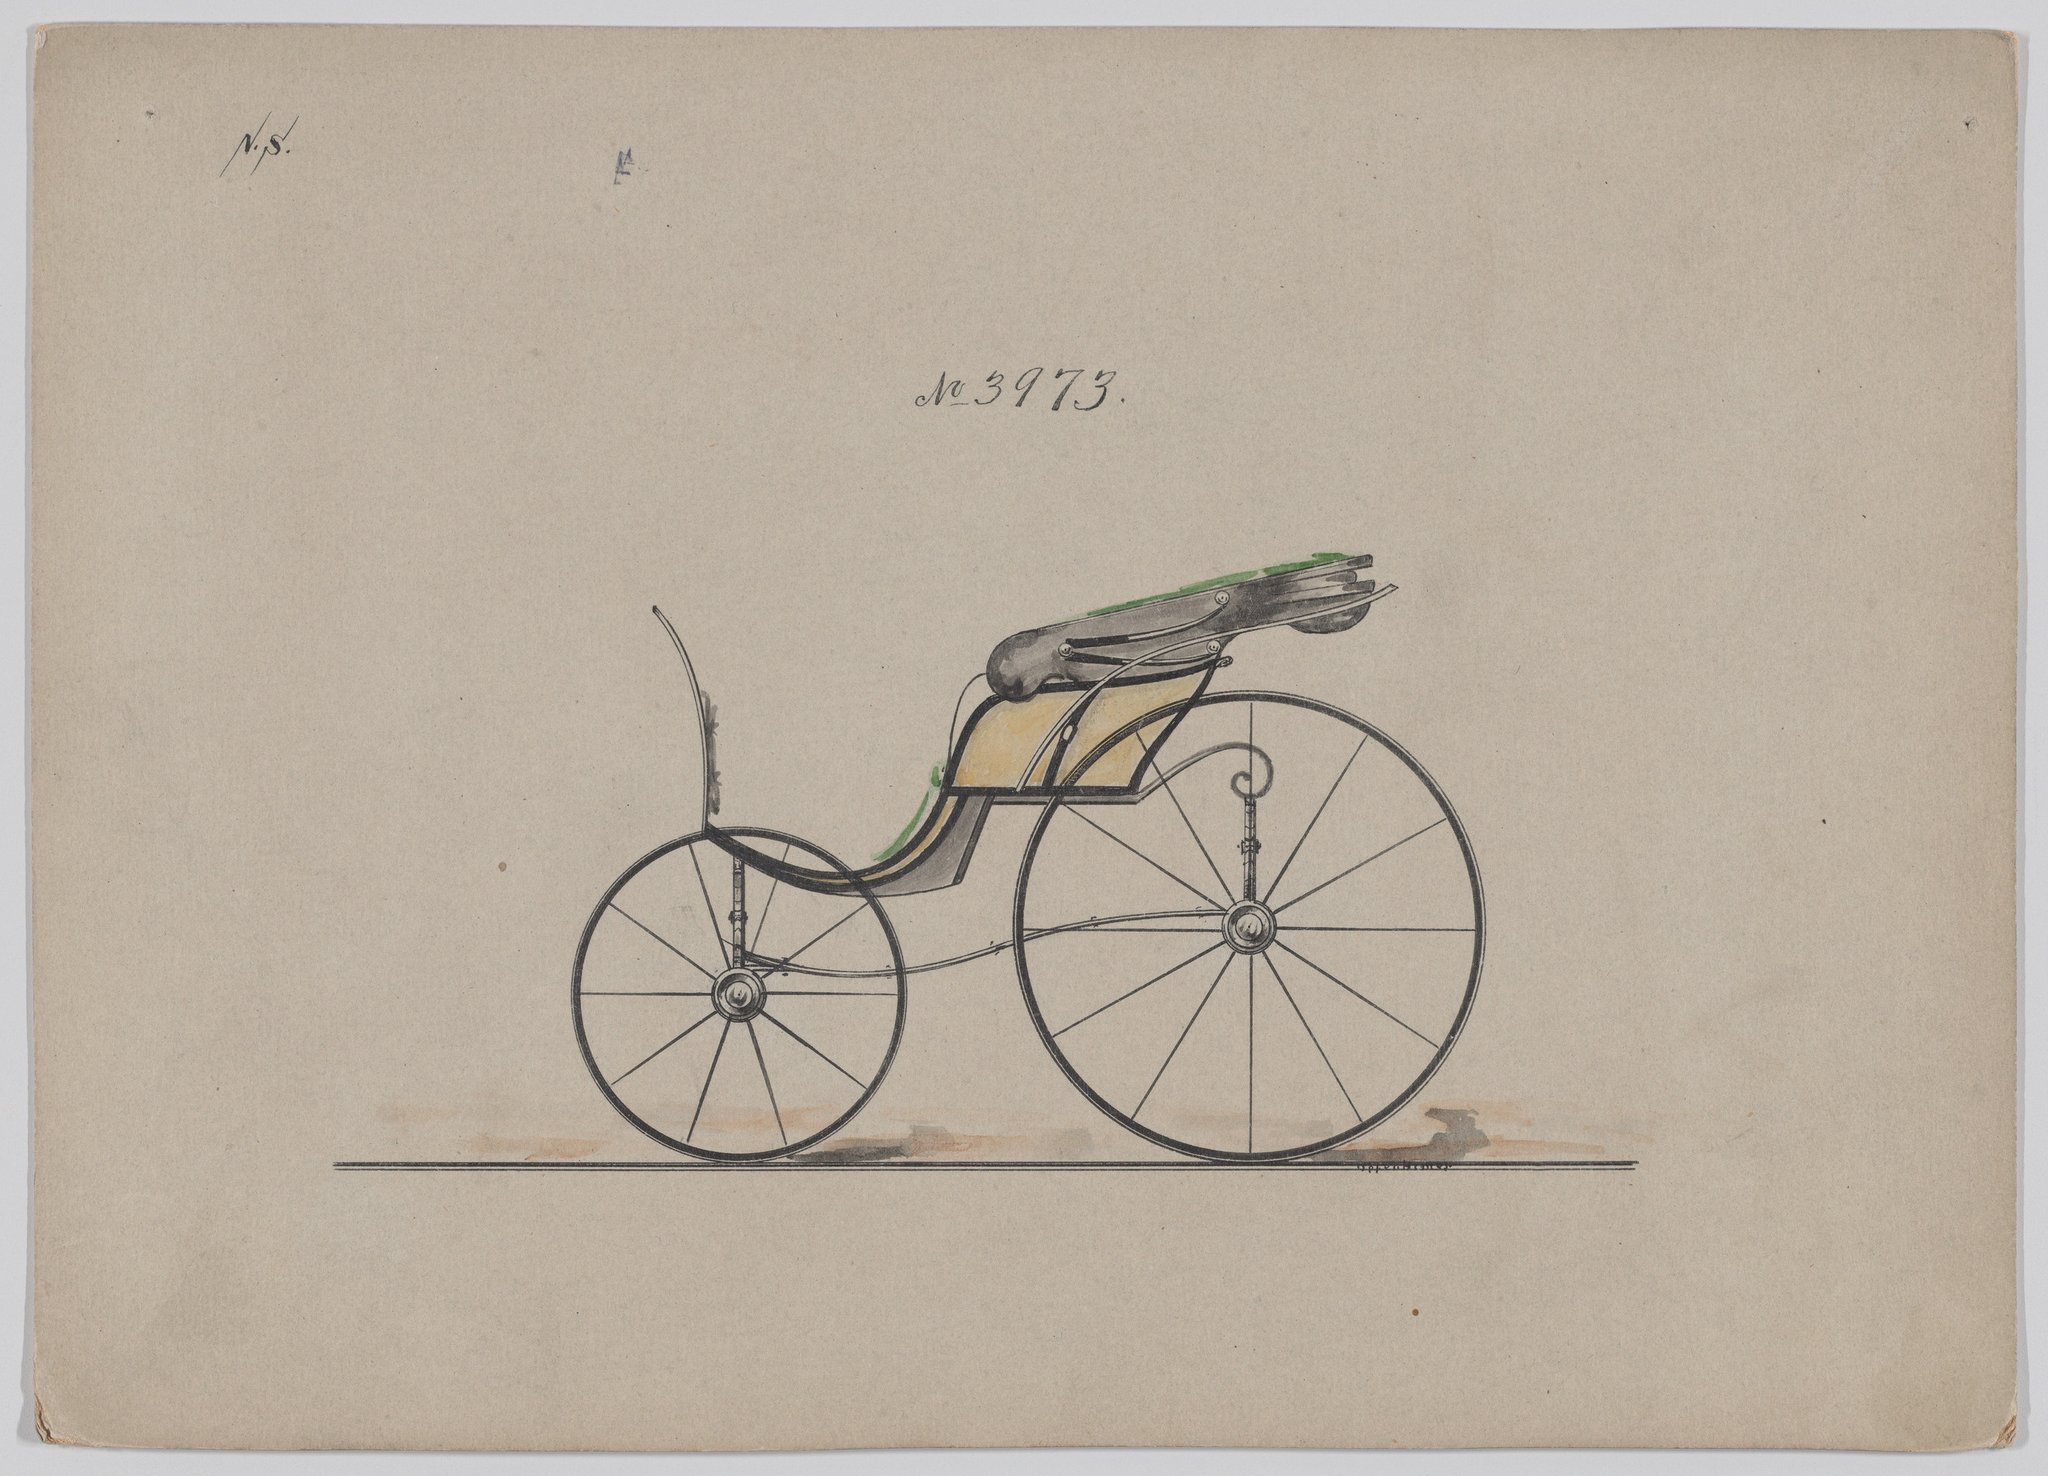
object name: drawing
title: Design for Pony Phaeton, no. 3973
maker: brewster & co.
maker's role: manufacturer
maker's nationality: american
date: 1886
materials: gouache, ink, watercolor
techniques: pen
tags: carriages